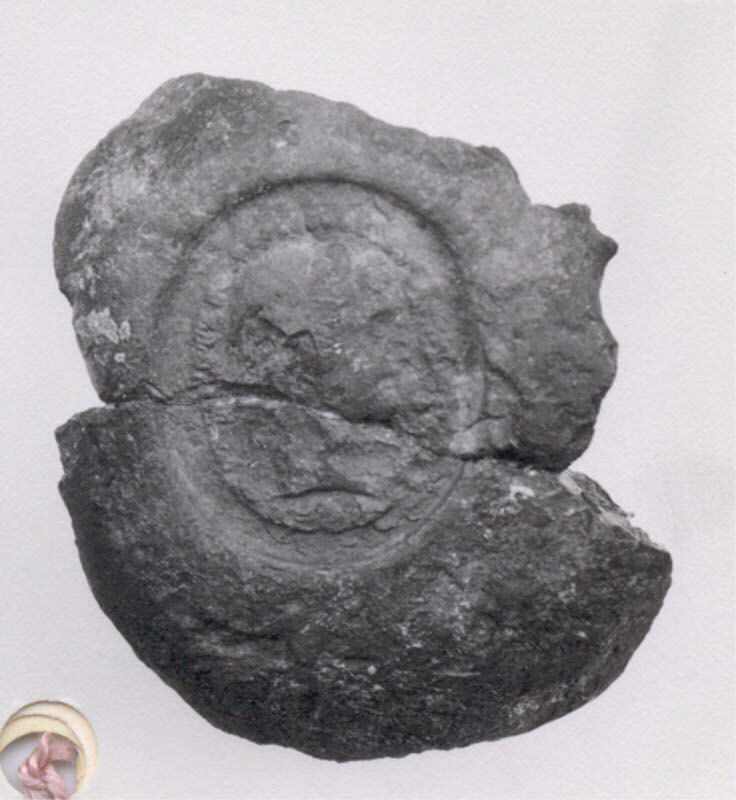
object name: sealing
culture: sasanian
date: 601-700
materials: clay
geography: iran